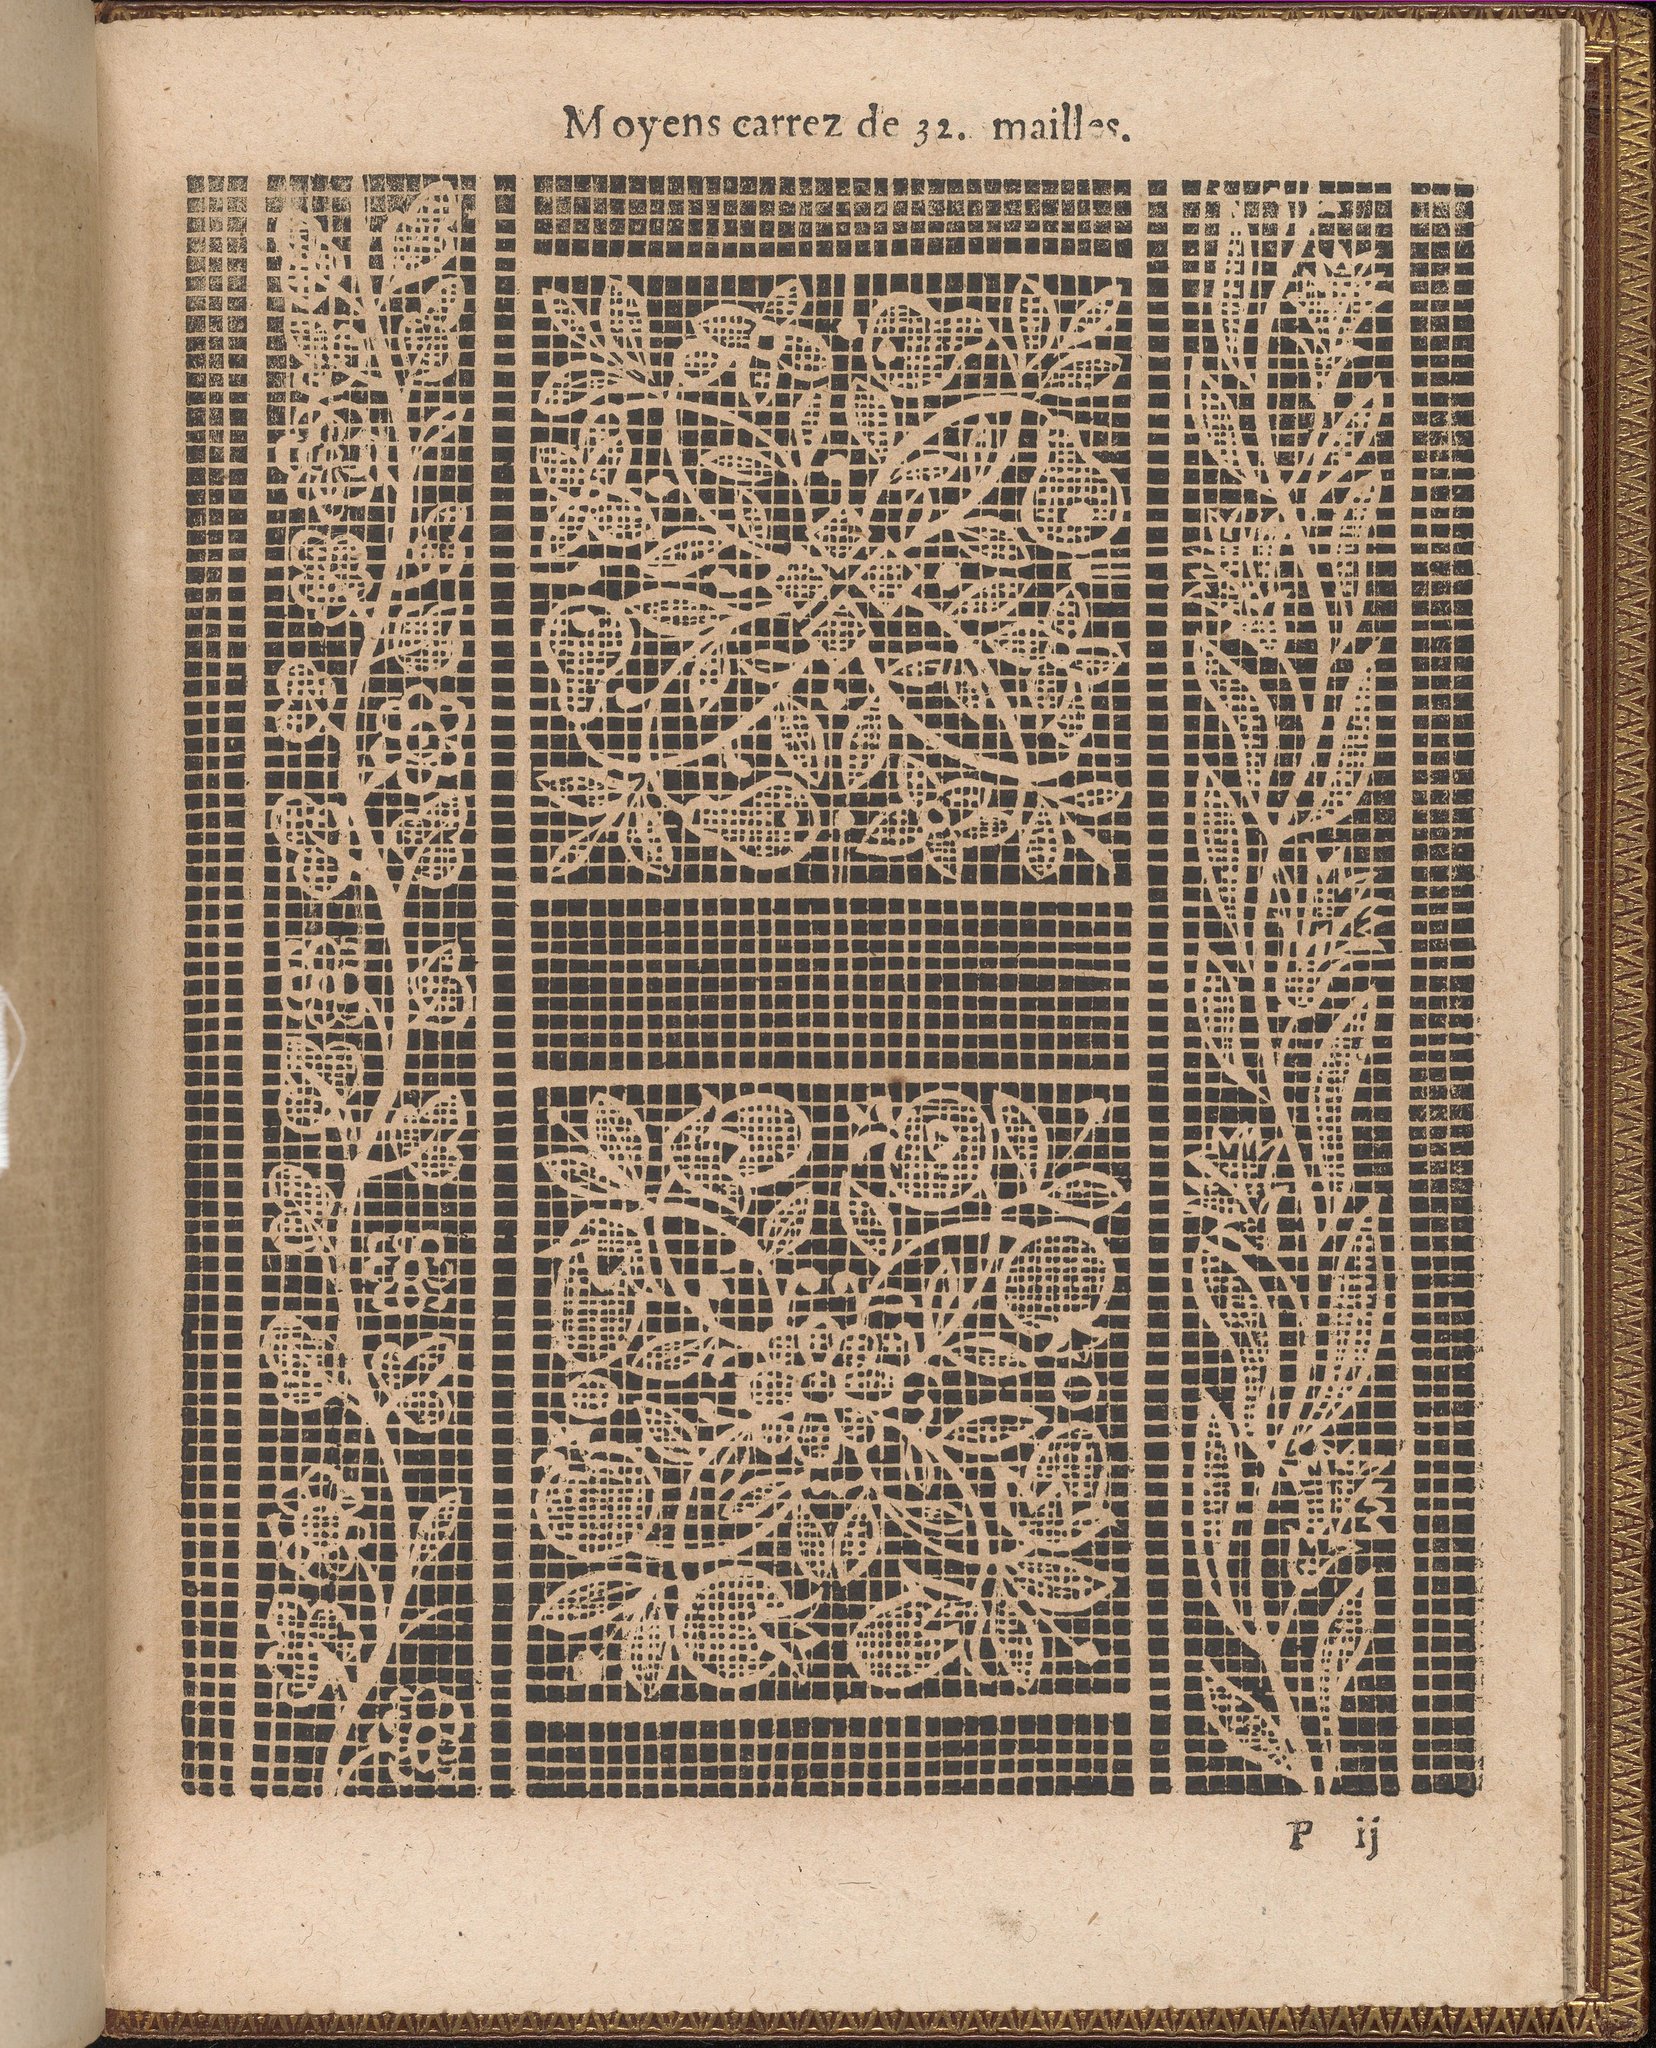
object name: book print ornament architecture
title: La Pratique de l'Aiguille, page 57 (recto)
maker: matthias mignerak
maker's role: author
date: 1605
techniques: woodcut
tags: ornament